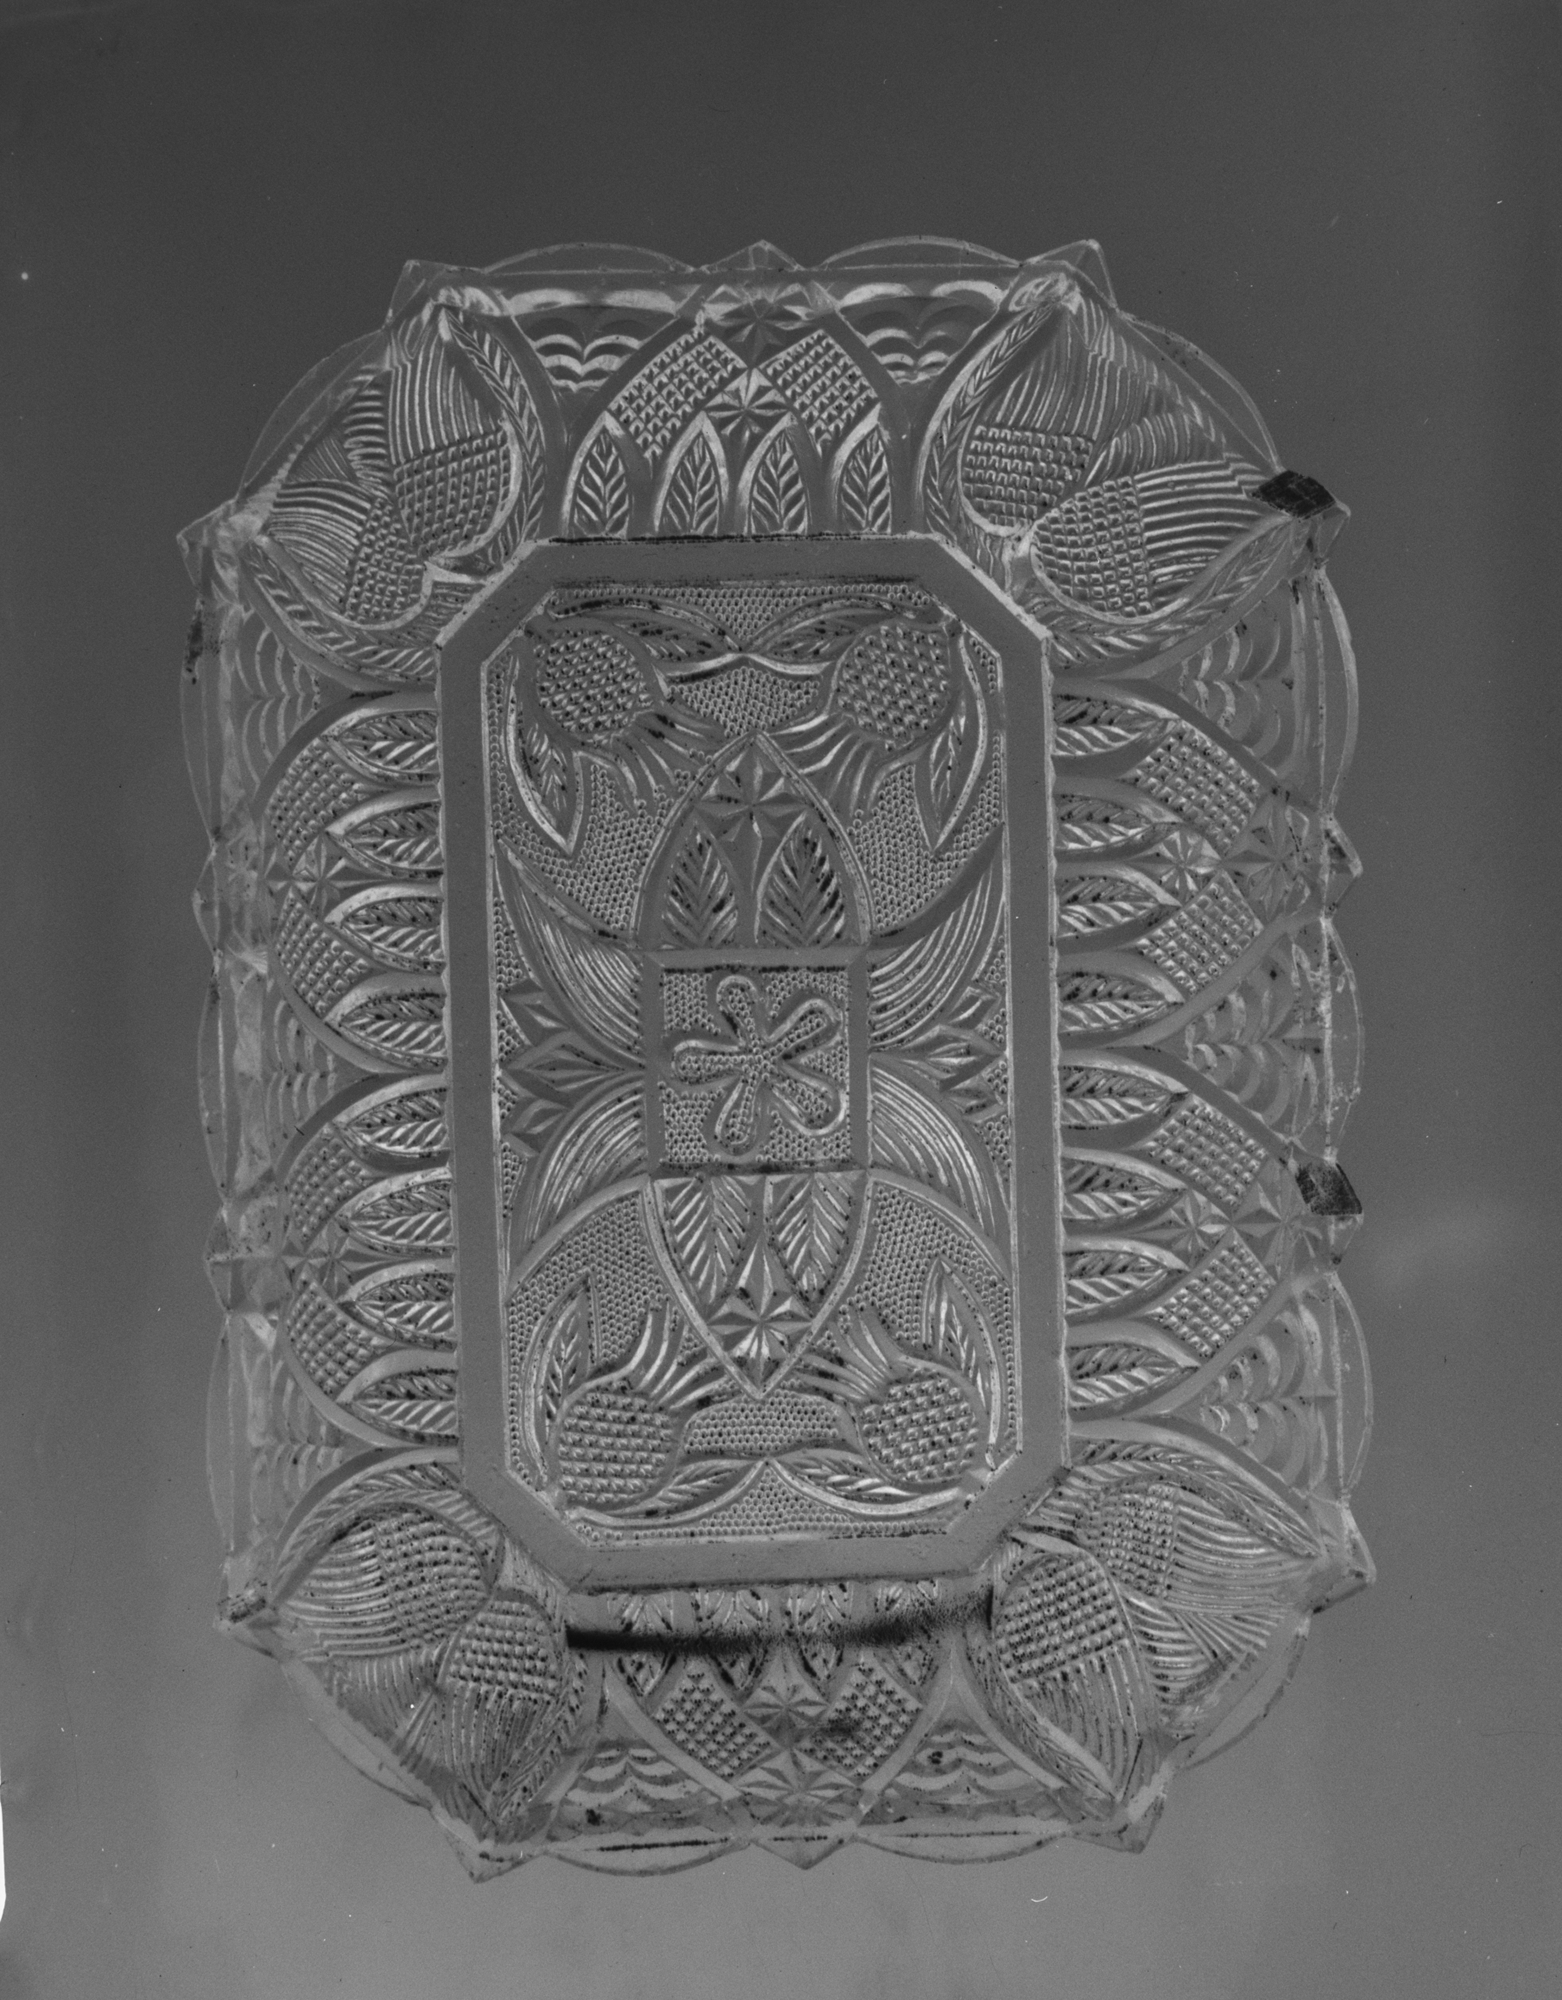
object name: dish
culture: american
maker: boston & sandwich glass company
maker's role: maker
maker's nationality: american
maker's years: 1825-1888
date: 1835-1845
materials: glass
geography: united states